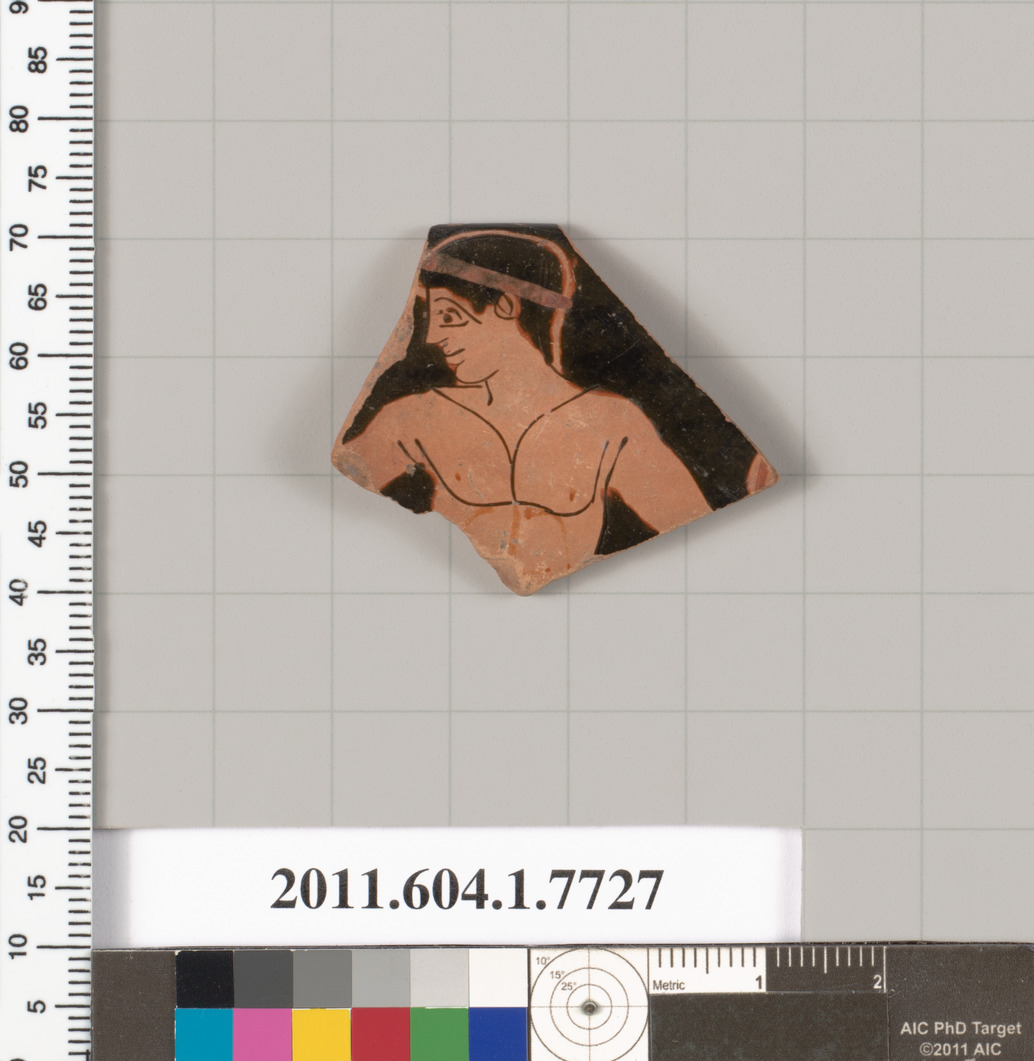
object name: kylix fragment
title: Terracotta rim fragment of a kylix (drinking cup)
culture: greek, attic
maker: orleans painter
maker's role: artist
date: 475-451 BCE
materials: terracotta